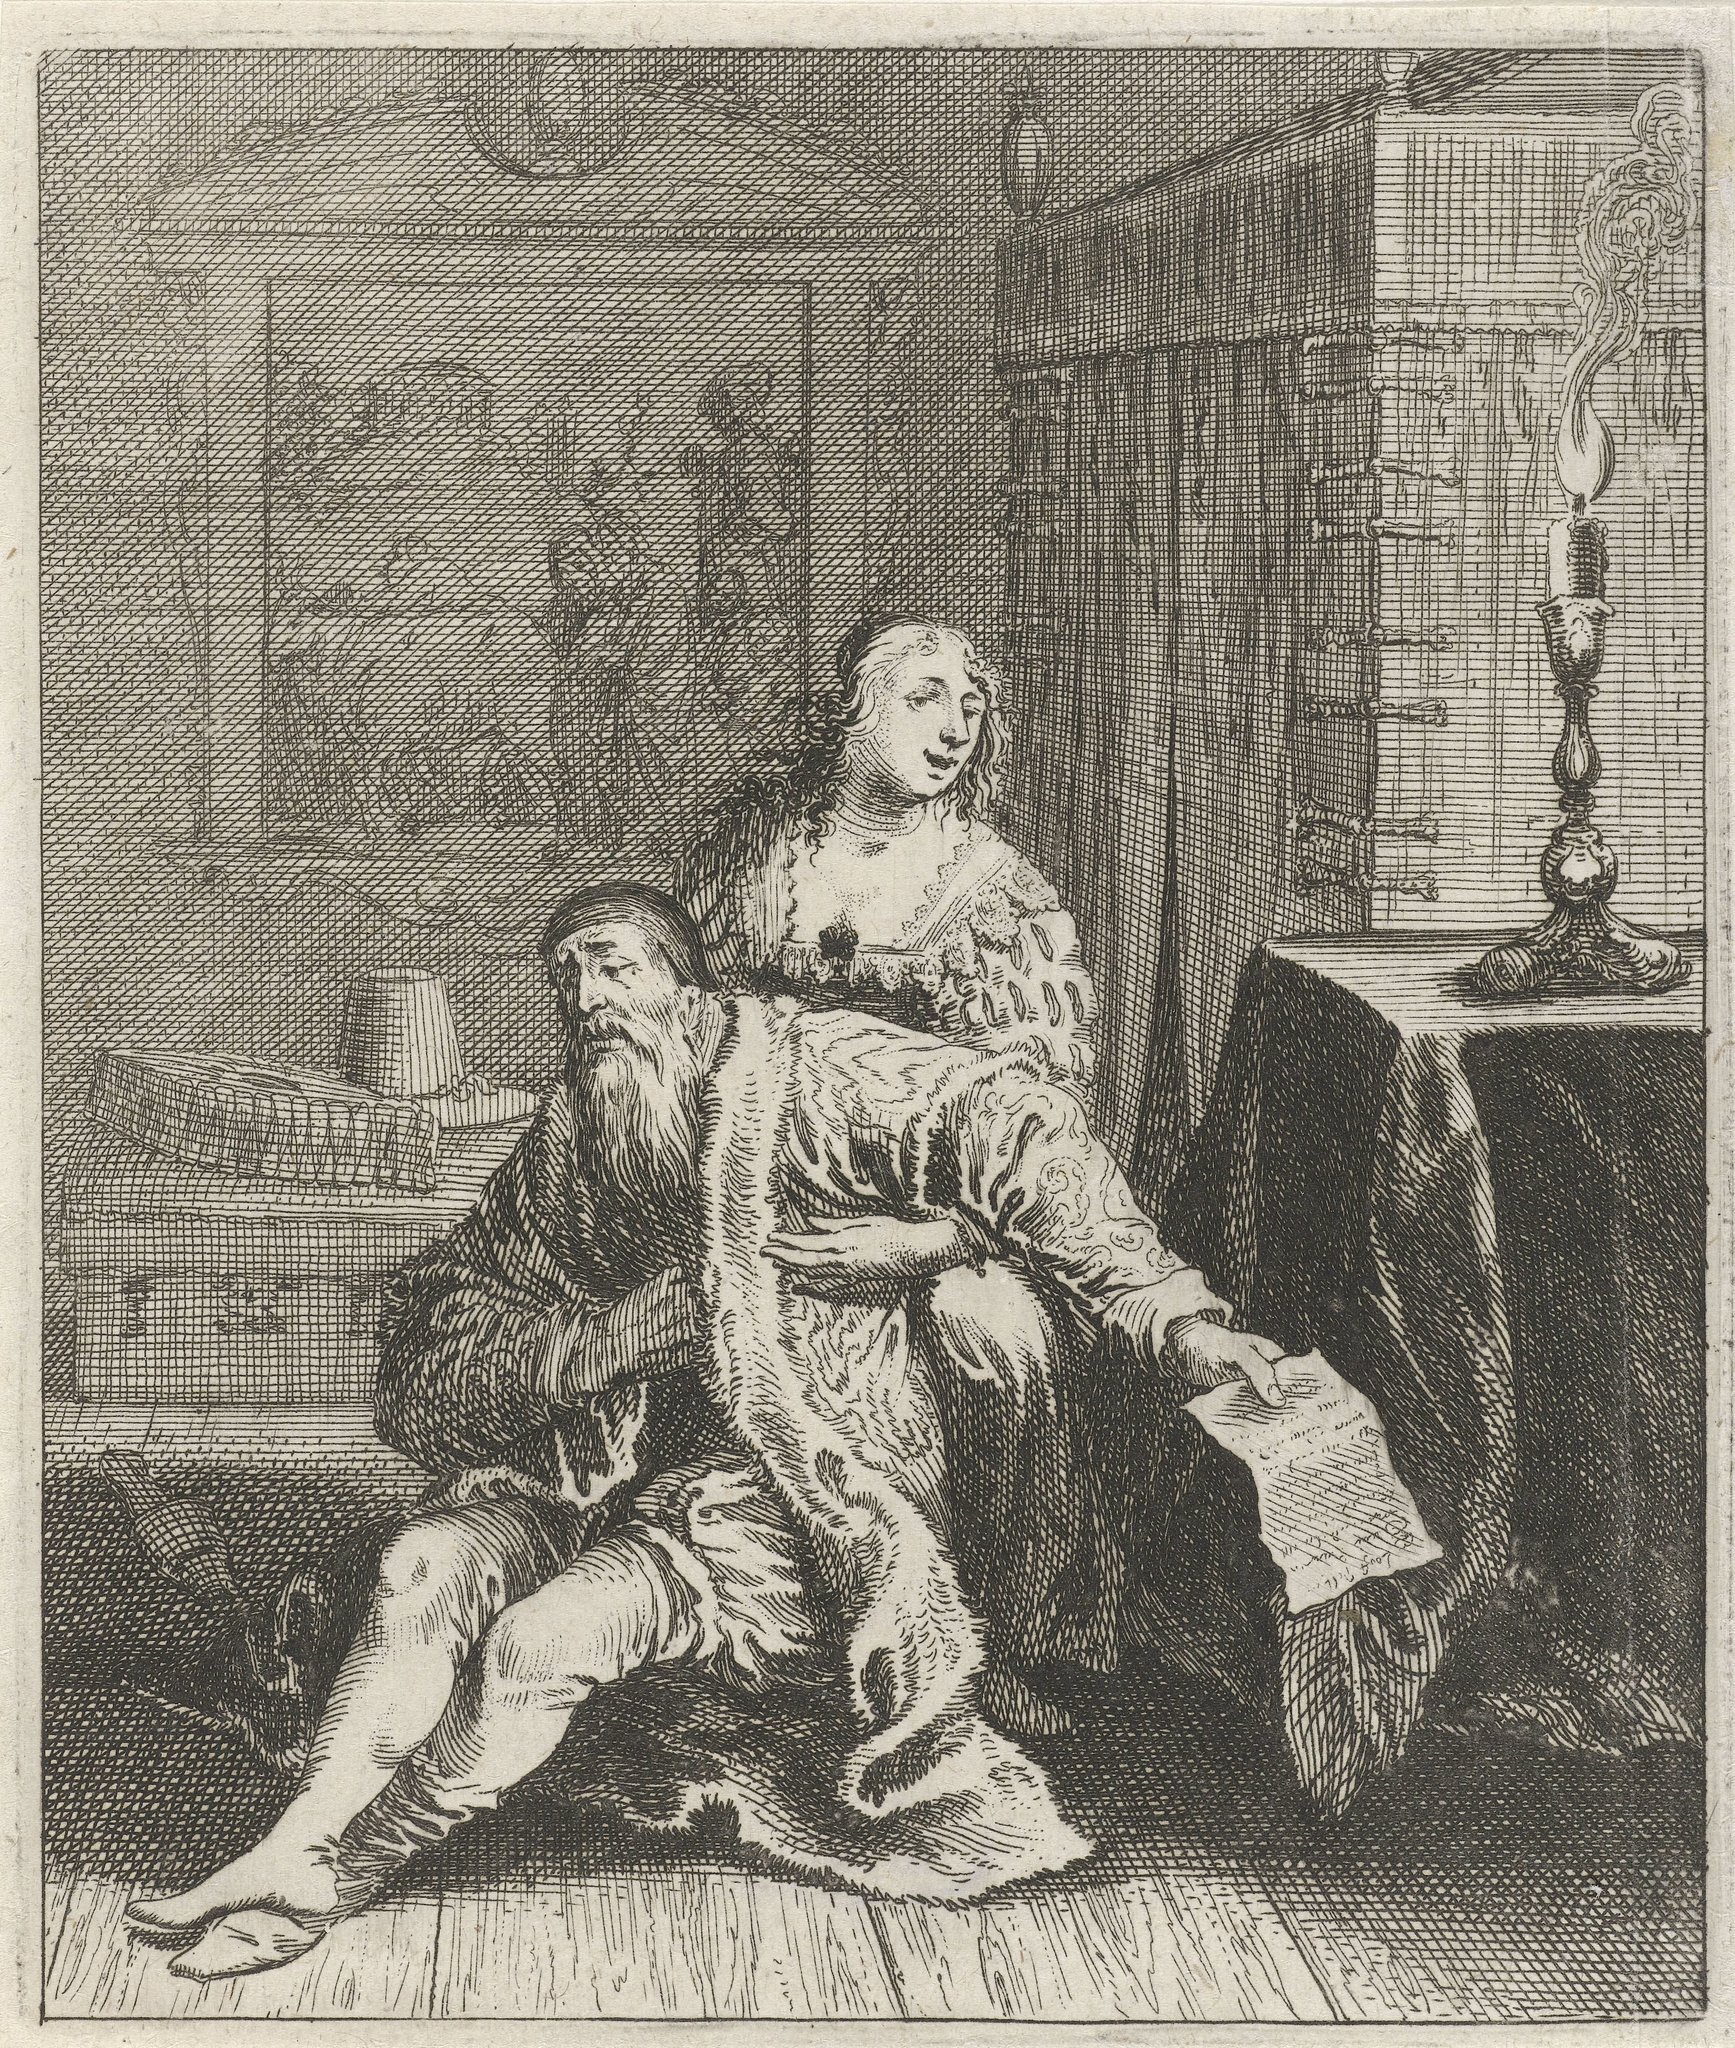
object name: print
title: Don Philippo en Eleonora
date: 1643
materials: paper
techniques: engraving, etching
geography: amsterdam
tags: fainting, swooning, wandering communities: romani or roma, preciosa, interior of the house, letter, envelope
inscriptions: collector's mark: Lugt 2228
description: In een interieur vangt Eleonora haar vader Don Philippo op, die flauwvalt na het lezen van een brief van zijn zoon Don Jan, waarin deze schrijft dat hij zijn ouderlijk huis verlaat om bij zijn geliefde te kunnen zijn. Prent uit een uitgave van het toneelstuk Het leven van Konstance, dat gaat over de adellijke Spaanse Konstance, die als kind werd ontvoerd door Roma.